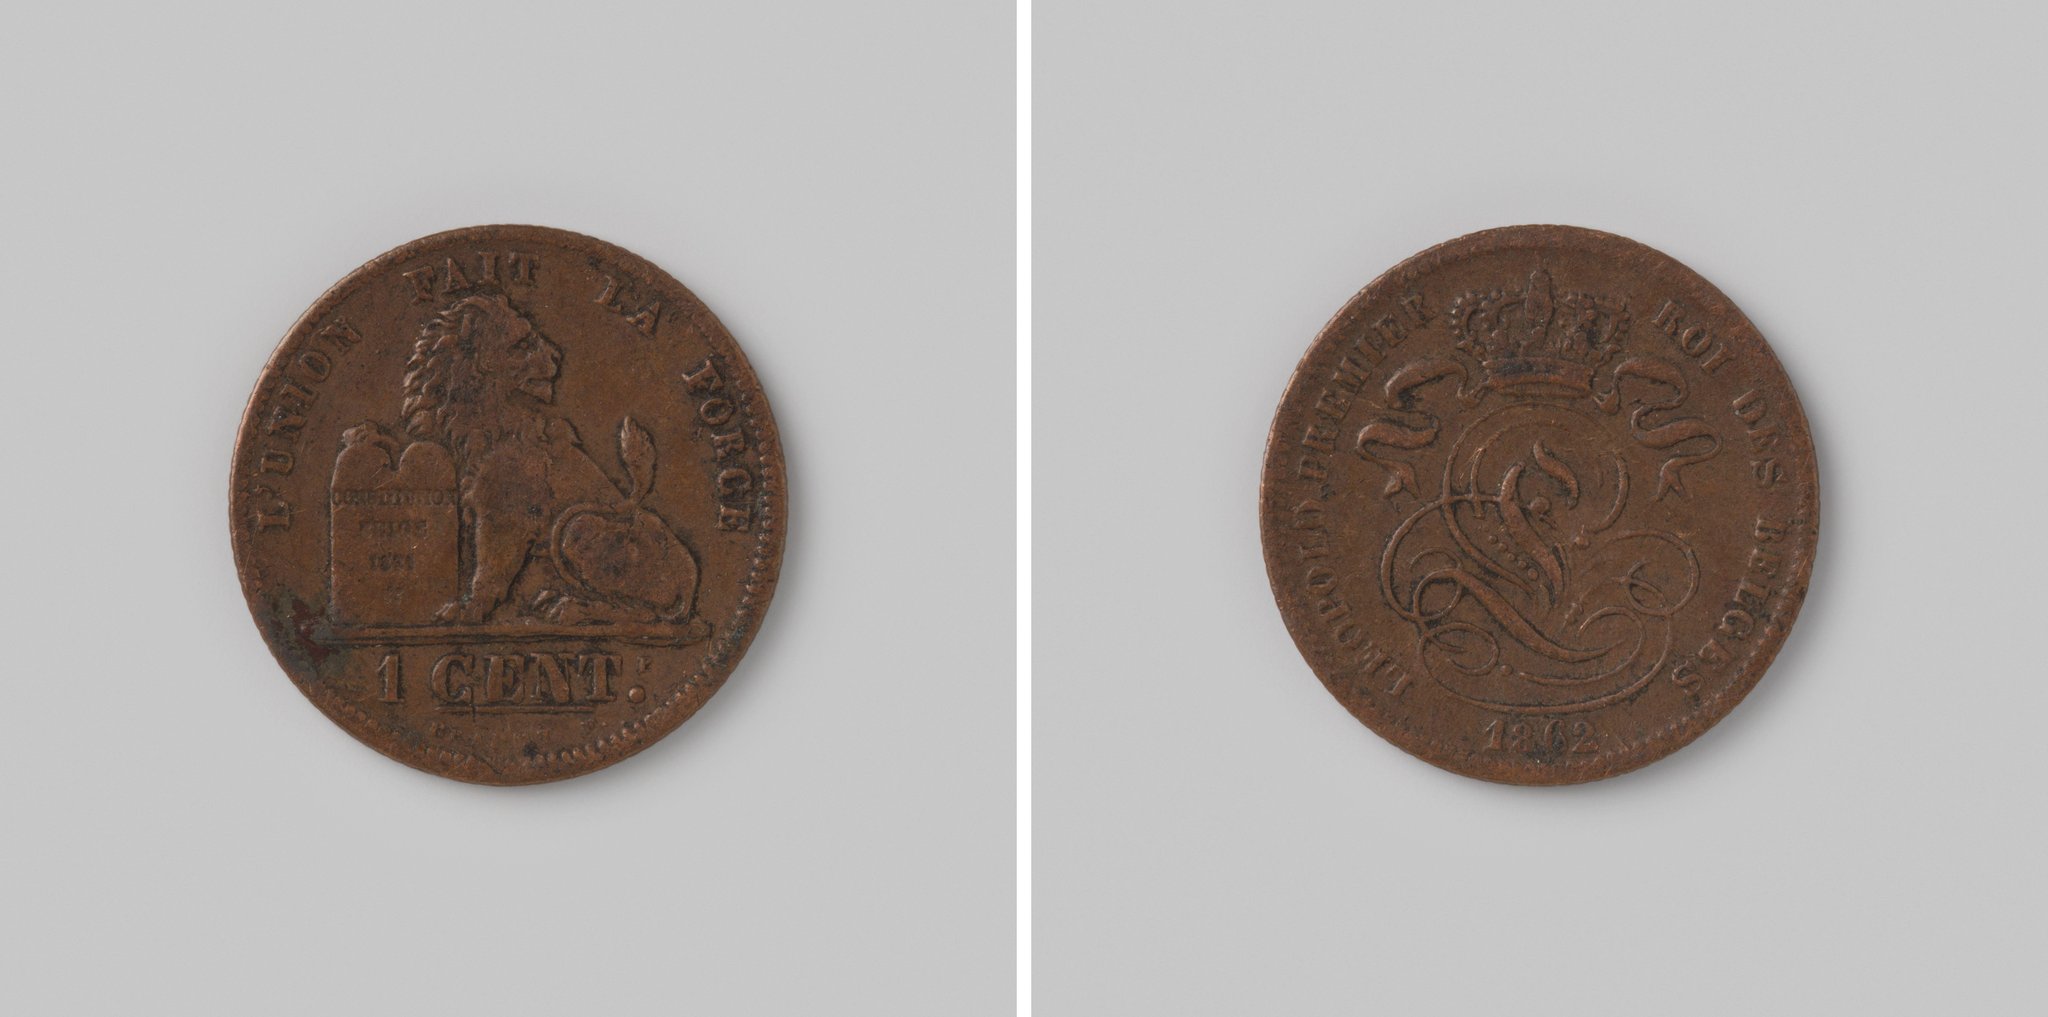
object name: coin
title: België, Leopold I, centime, 1862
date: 1862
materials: copper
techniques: striking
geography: brussels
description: Koperen munt. Voorzijde: zittende, omkijkende leeuw naar links met onder rechter klauw paneel met opschrift. In afsnede waarde-aanduiding. Keerzijde: gekroond monogram. Jaartal onderaan. Kartelrand.